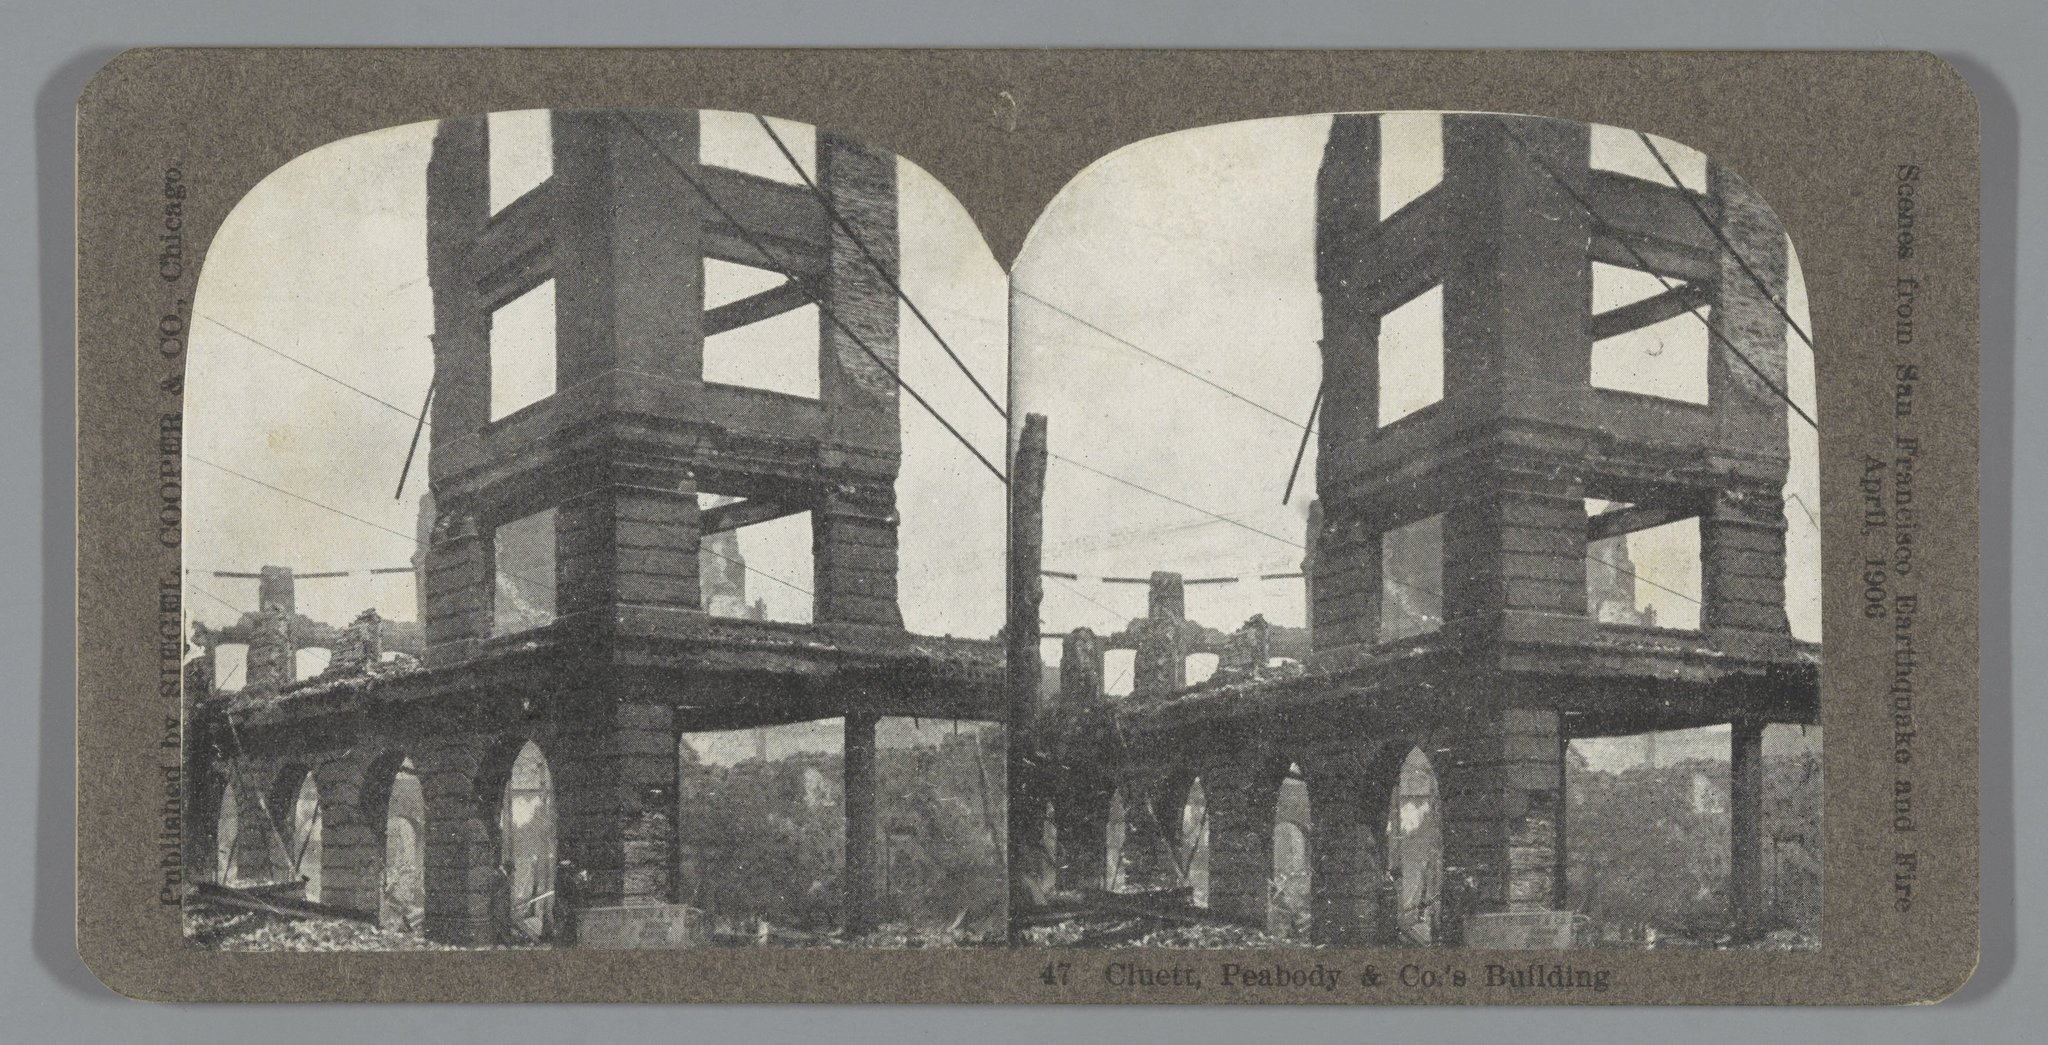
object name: stereograph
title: Scenes from San Francisco Eartquake and Fire, April, 1906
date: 1906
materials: cardboard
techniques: autotype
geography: san francisco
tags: ruin of a building ~ architecture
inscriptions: number: ‘47’, copyright notice: ‘COPYRIGHT BY TOM M. PHILLIPS/ 1906’